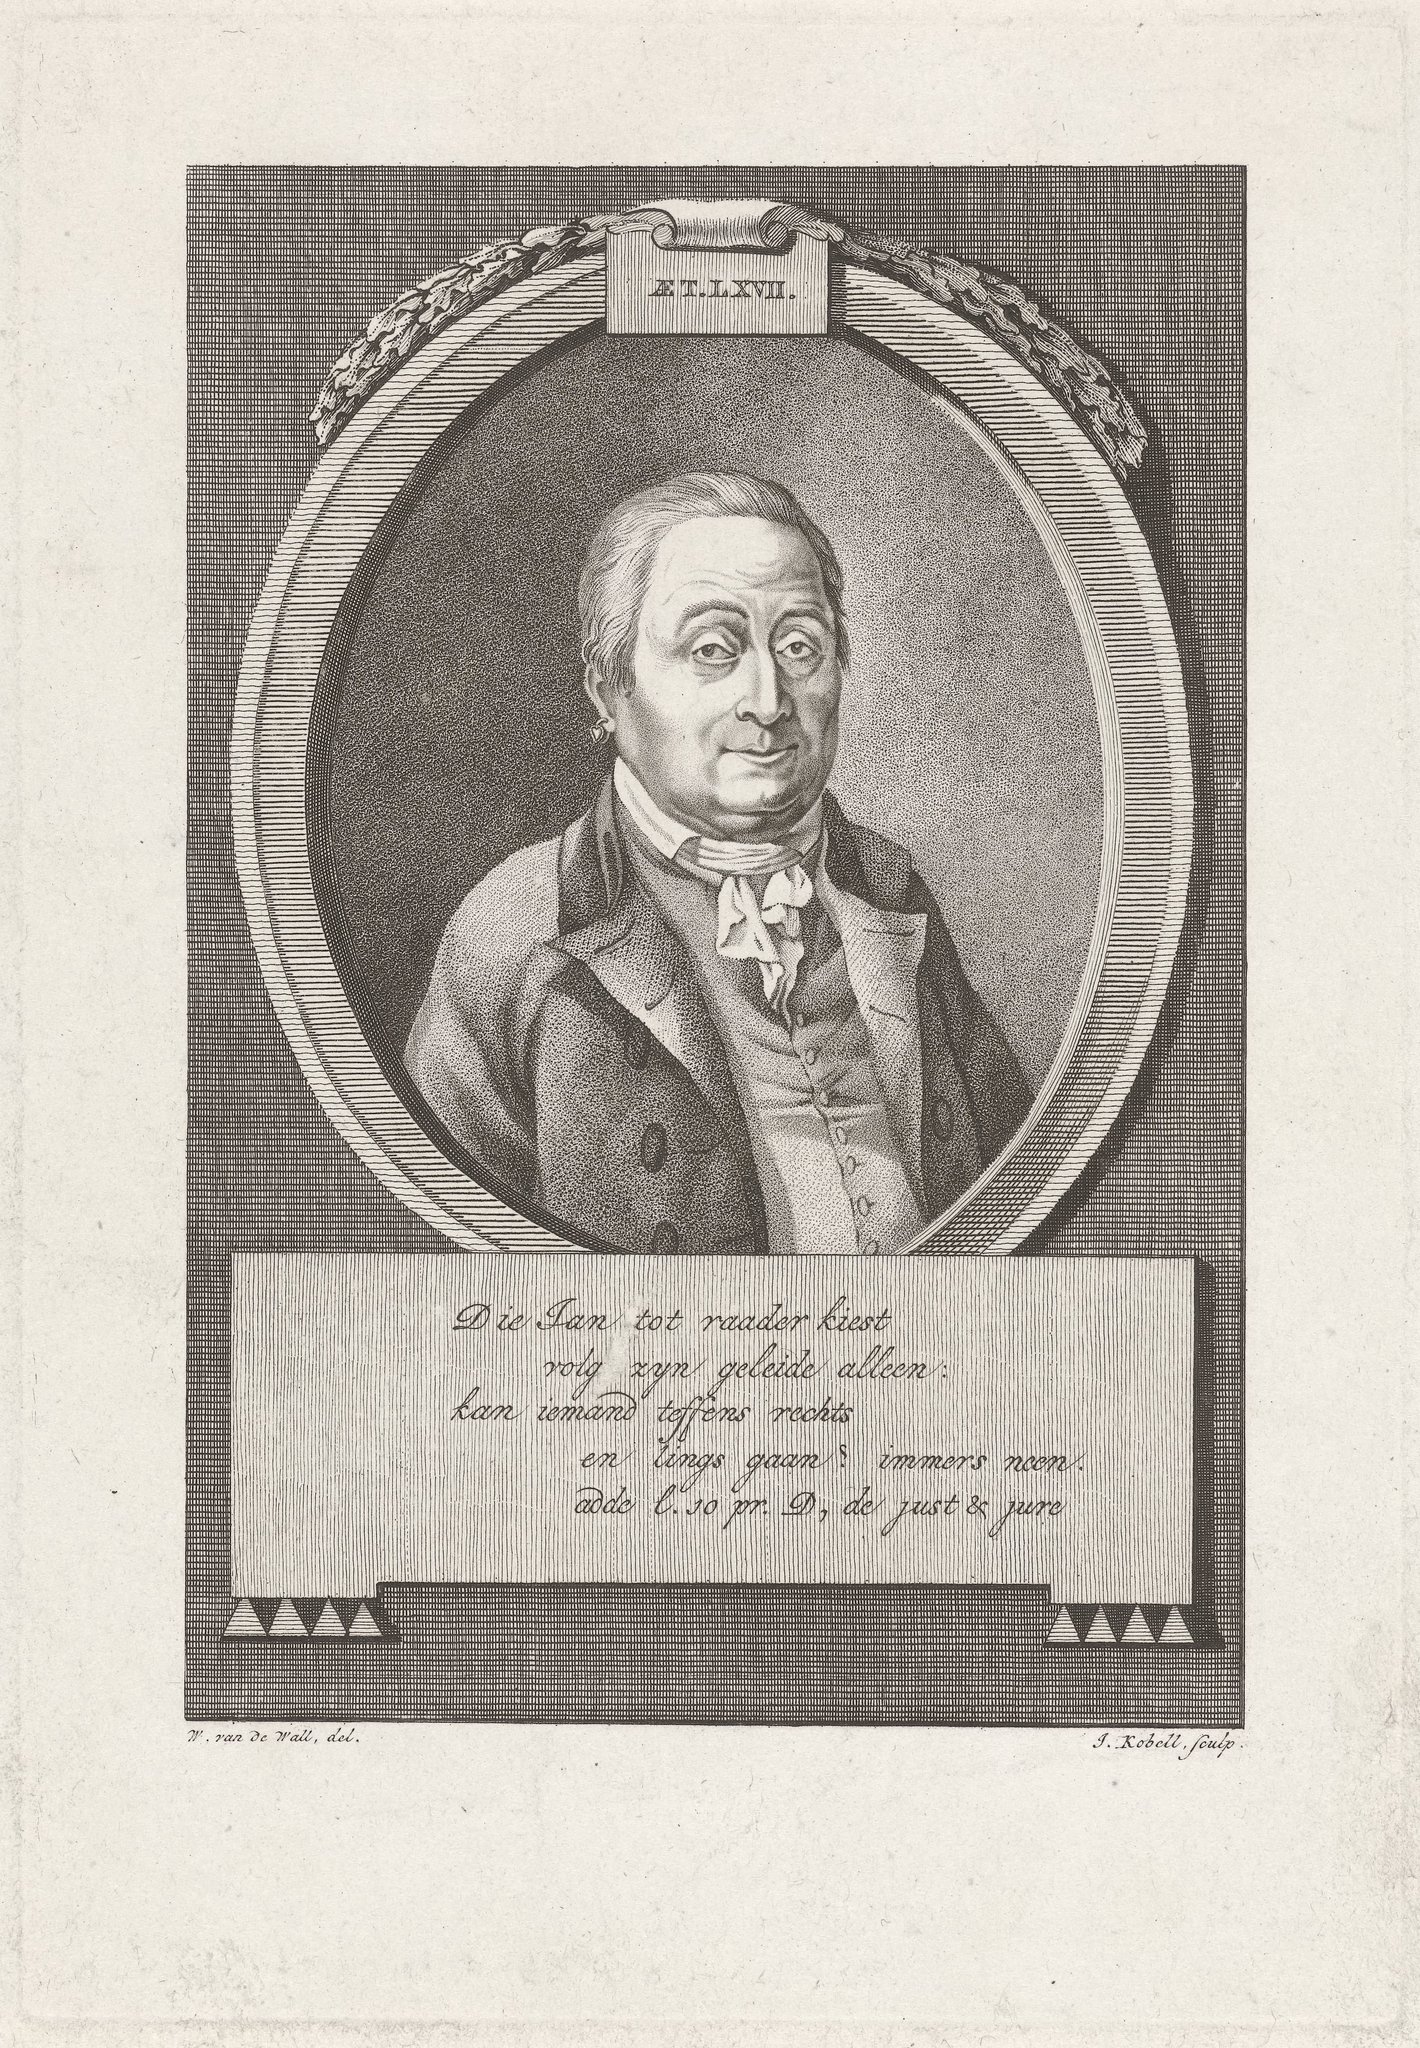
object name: print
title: Portret van Jan van der Meersch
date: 1766-1833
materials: paper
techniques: engraving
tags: advocaat, jan van der meersch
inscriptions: collector's mark: Lugt 2228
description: Portretbuste van de advocaat Jan van der Meersch, op zevenenzestigjarige leeftijd. Onder het portret een vijfregelig vers.